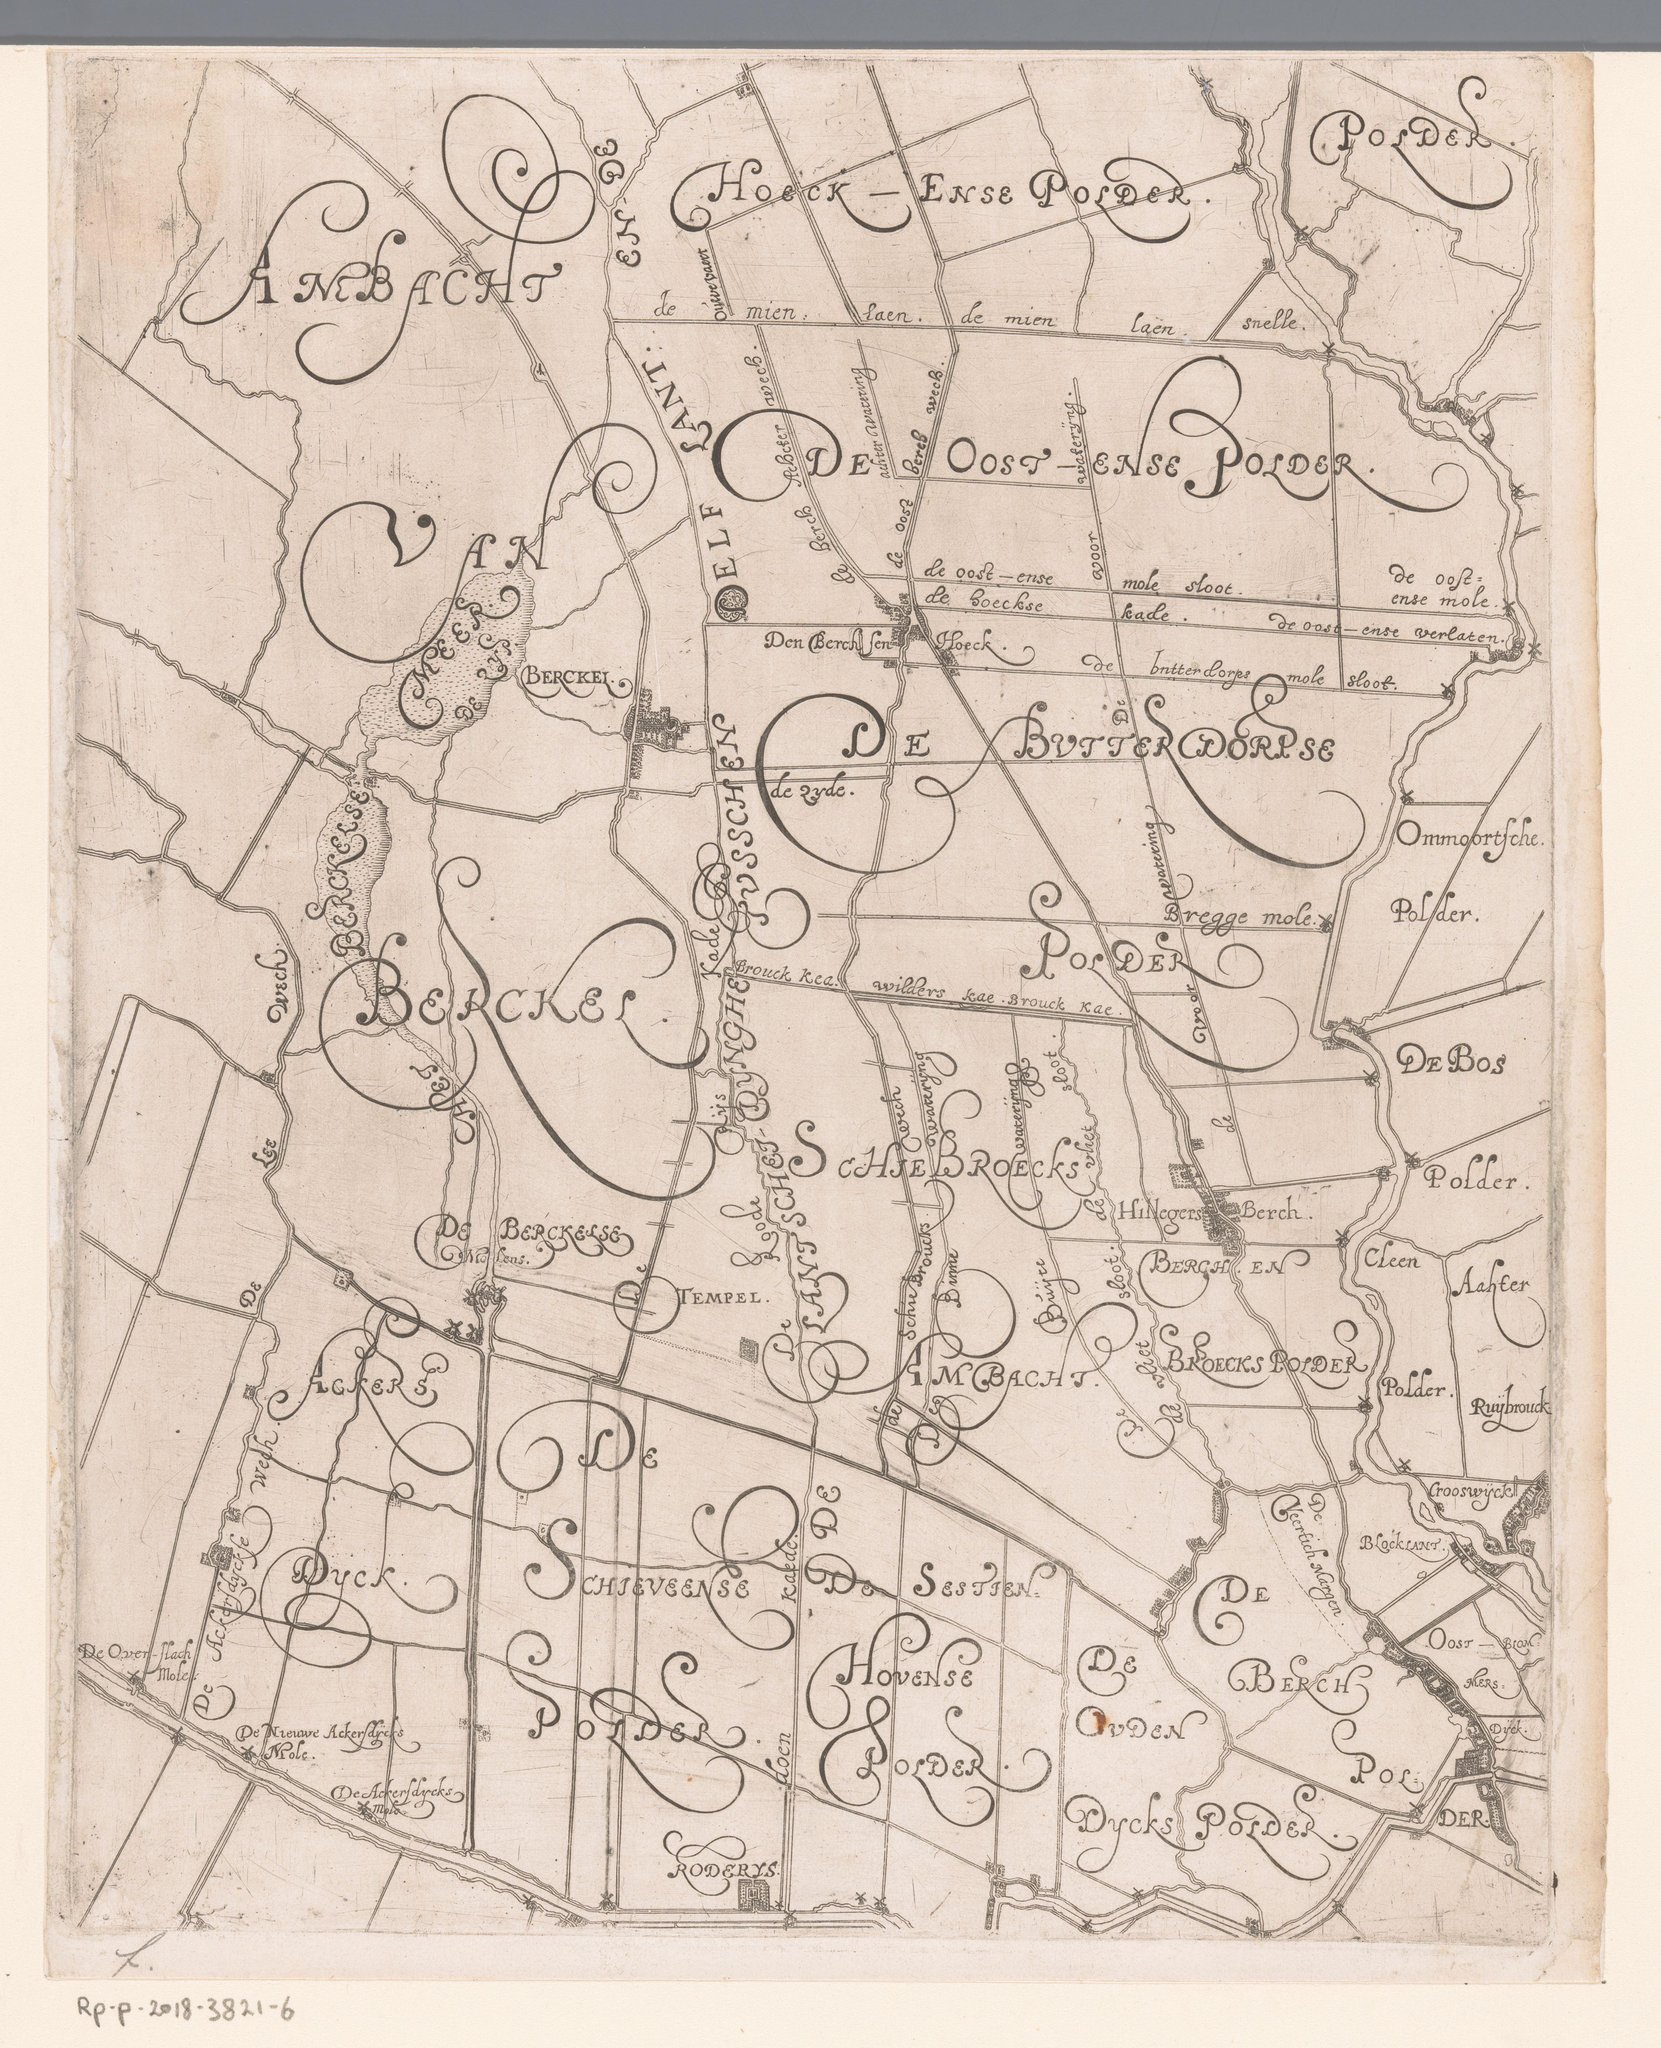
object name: print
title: Kaart van het Hoogheemraadschap van Delfland, met Berkel en Rodenrijs, deel midden rechts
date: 1611-1692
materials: paper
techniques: engraving, etching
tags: maps of separate countries or regions